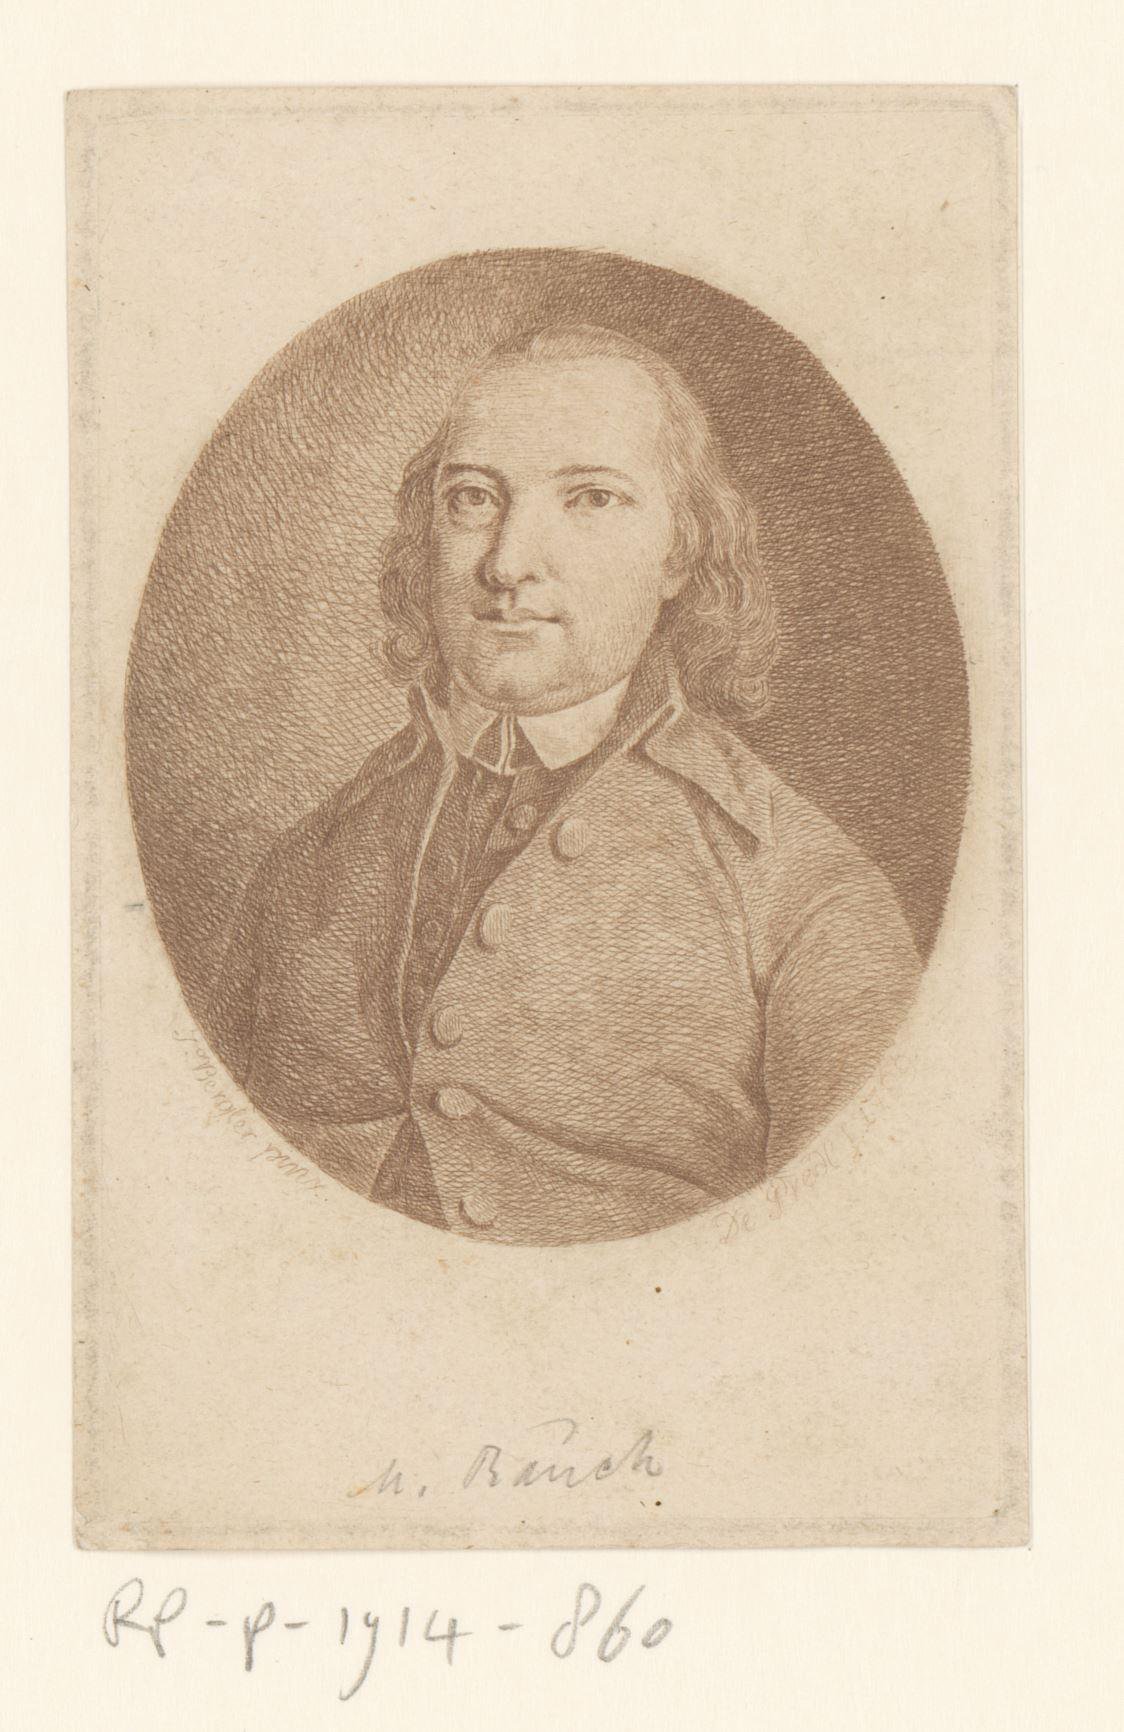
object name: print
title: Portret van M. Rauch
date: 1790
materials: paper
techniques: engraving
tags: historical persons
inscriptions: collector's mark: Lugt 2228